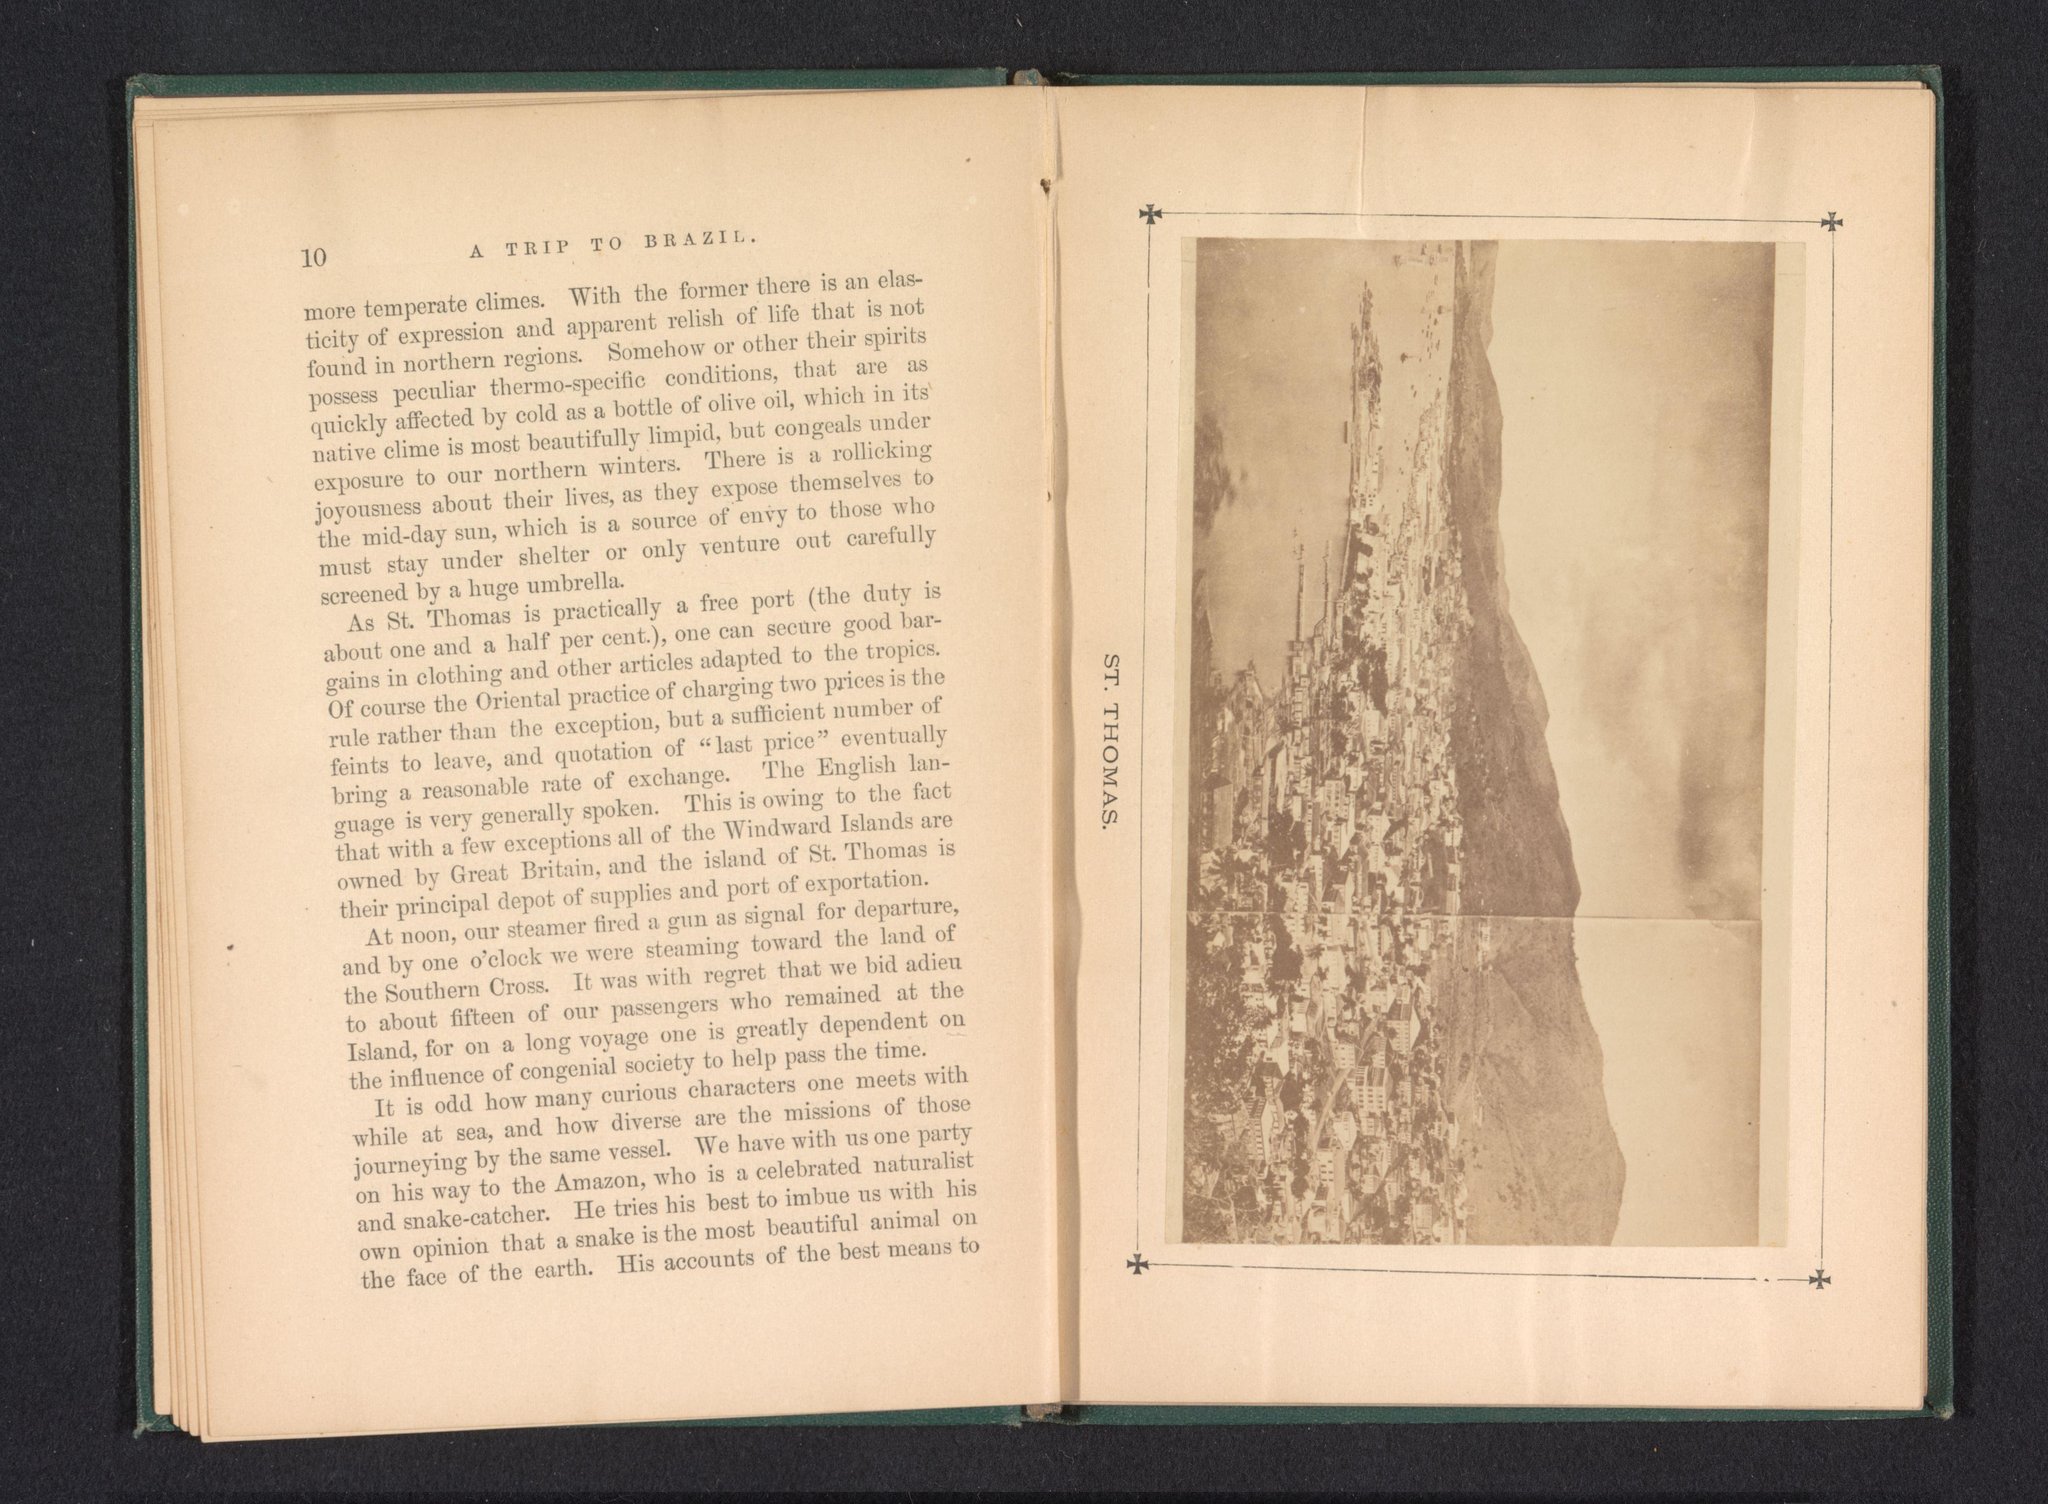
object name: photograph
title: St. Thomas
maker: Anonymous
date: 1864-1874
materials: photographic support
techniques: albumen print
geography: saint thomas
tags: harbour, island